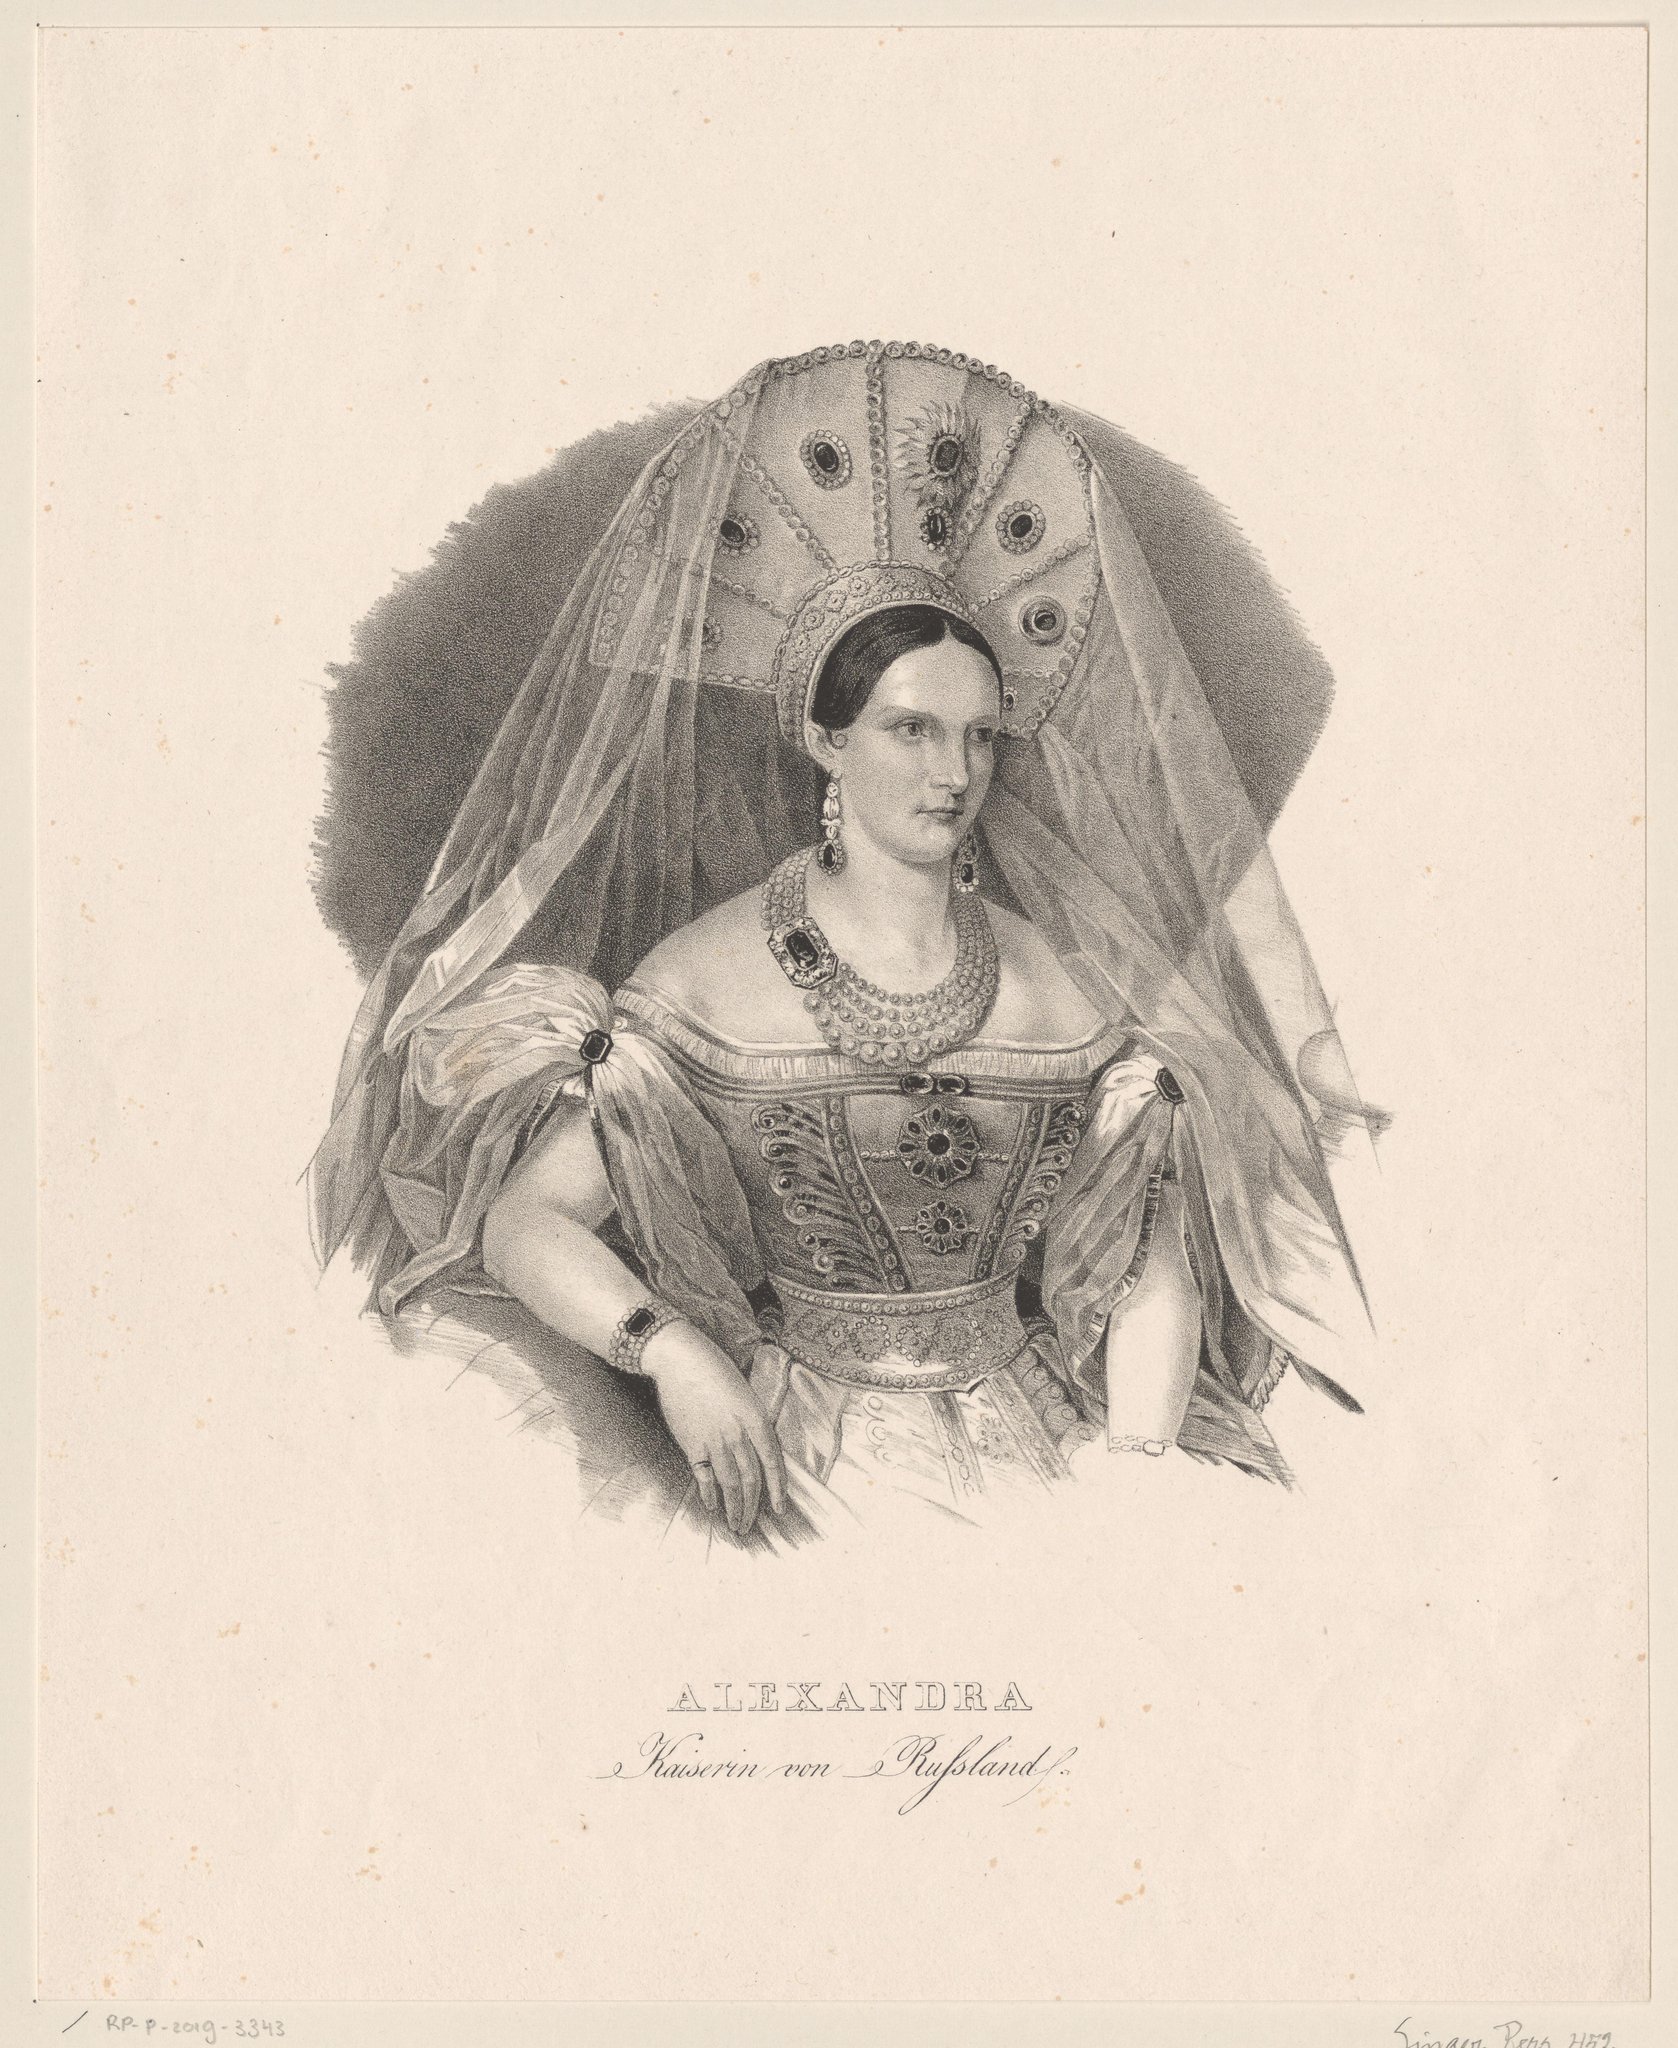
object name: print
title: Portret van Alexandra Fjodorovna, tsarina van Rusland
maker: Anonymous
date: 1817-1850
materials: paper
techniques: lithograph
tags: berlin, head-gear, historical persons - bb - woman, emperor - bb - female ruler